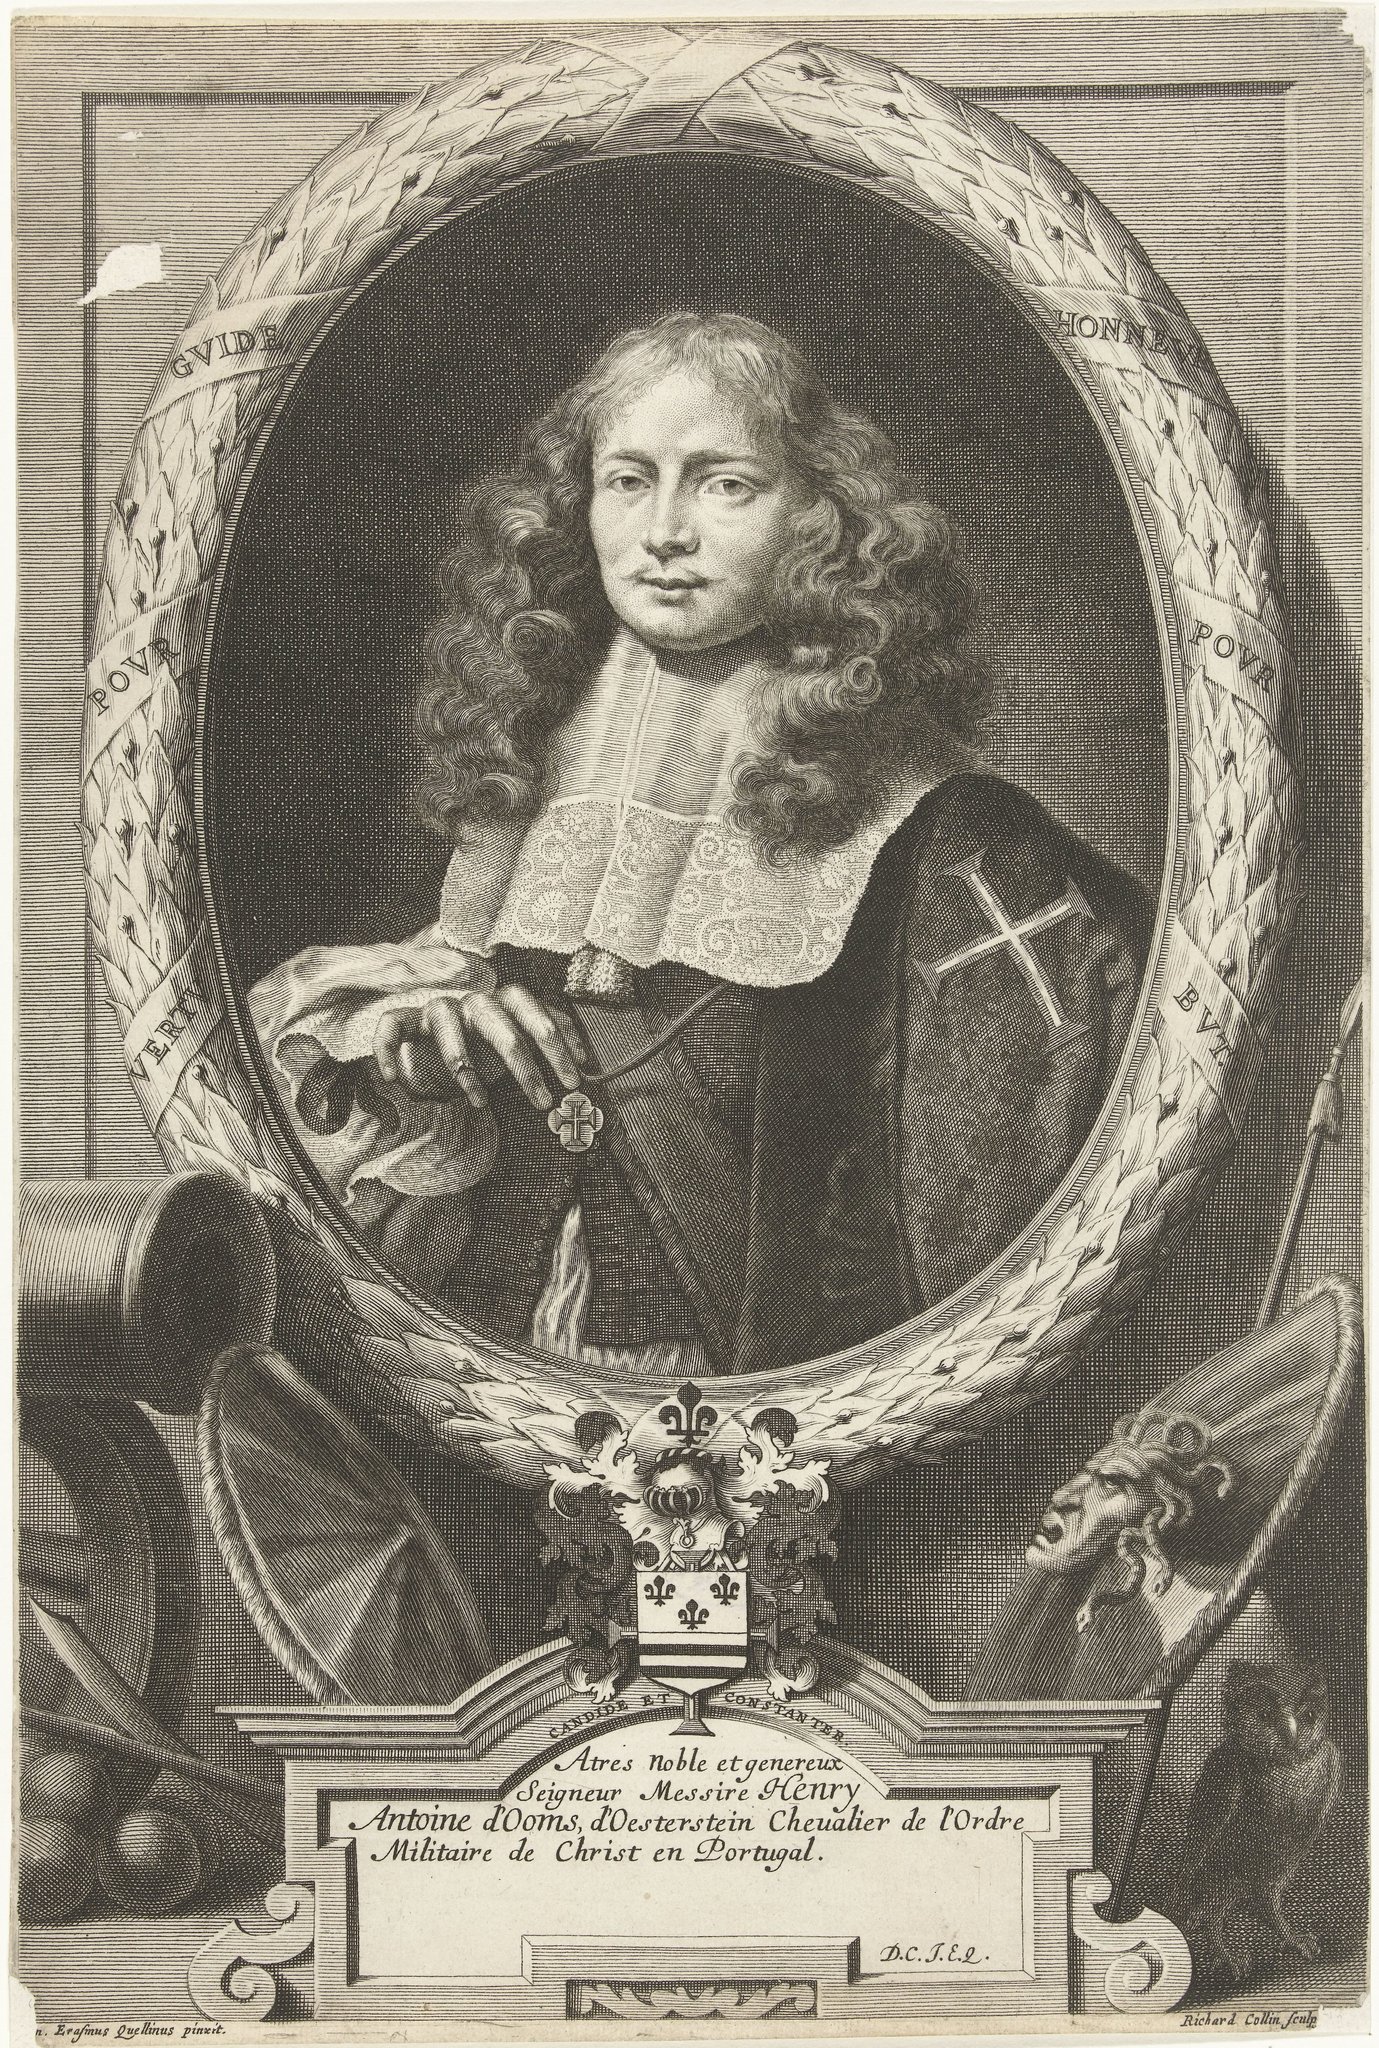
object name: print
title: Portret van Henri-Antoine d'Ooms d'Oesterstein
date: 1650-1694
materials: paper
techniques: engraving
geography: southern netherlands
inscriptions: collector's mark: Lugt 2228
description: Portret van de ridder Henri-Antoine d'Ooms d'Oesterstein in ovaal. Onder het portret zijn naam, familiewapen en titels. Ooms d'Oesterstein toont een hanger met een Grieks kruis teken van de Portugese Orde van Christus.